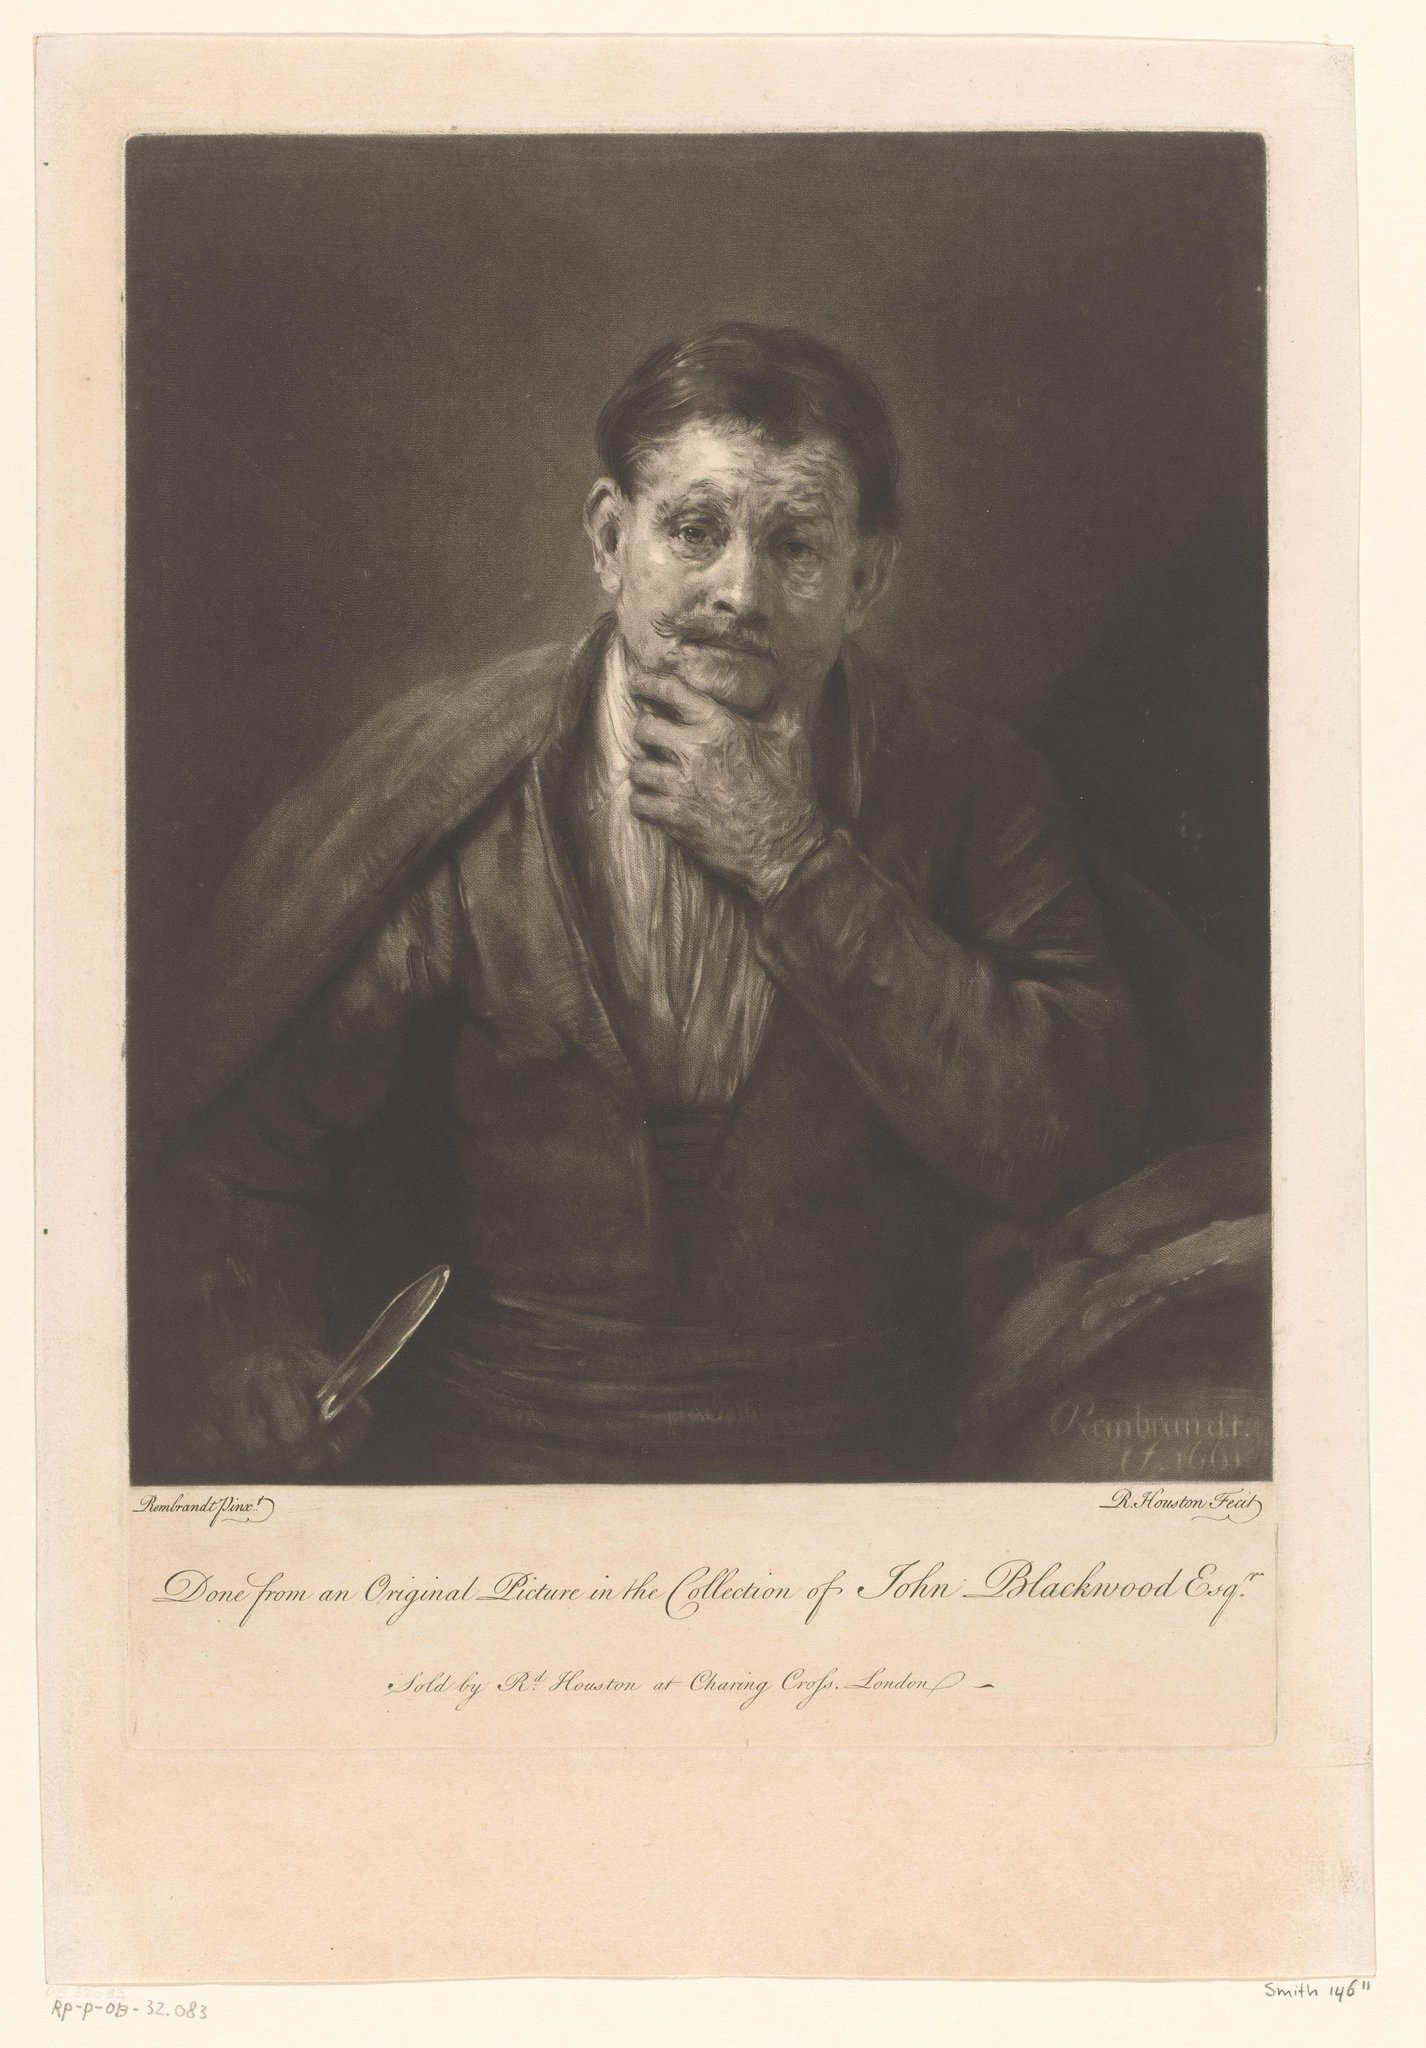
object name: print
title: Man met een mes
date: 1661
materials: paper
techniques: mezzotint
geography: london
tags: the apostle bartholomew; possible attributes: book, devil or dragon at feet, knife, scroll, flayed skin, staff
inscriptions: collector's mark: Lugt 240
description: Het schilderij waarop deze prent is gebaseerd bevindt zich in het J. Paul Getty Museum in Los Angeles/Malibu.